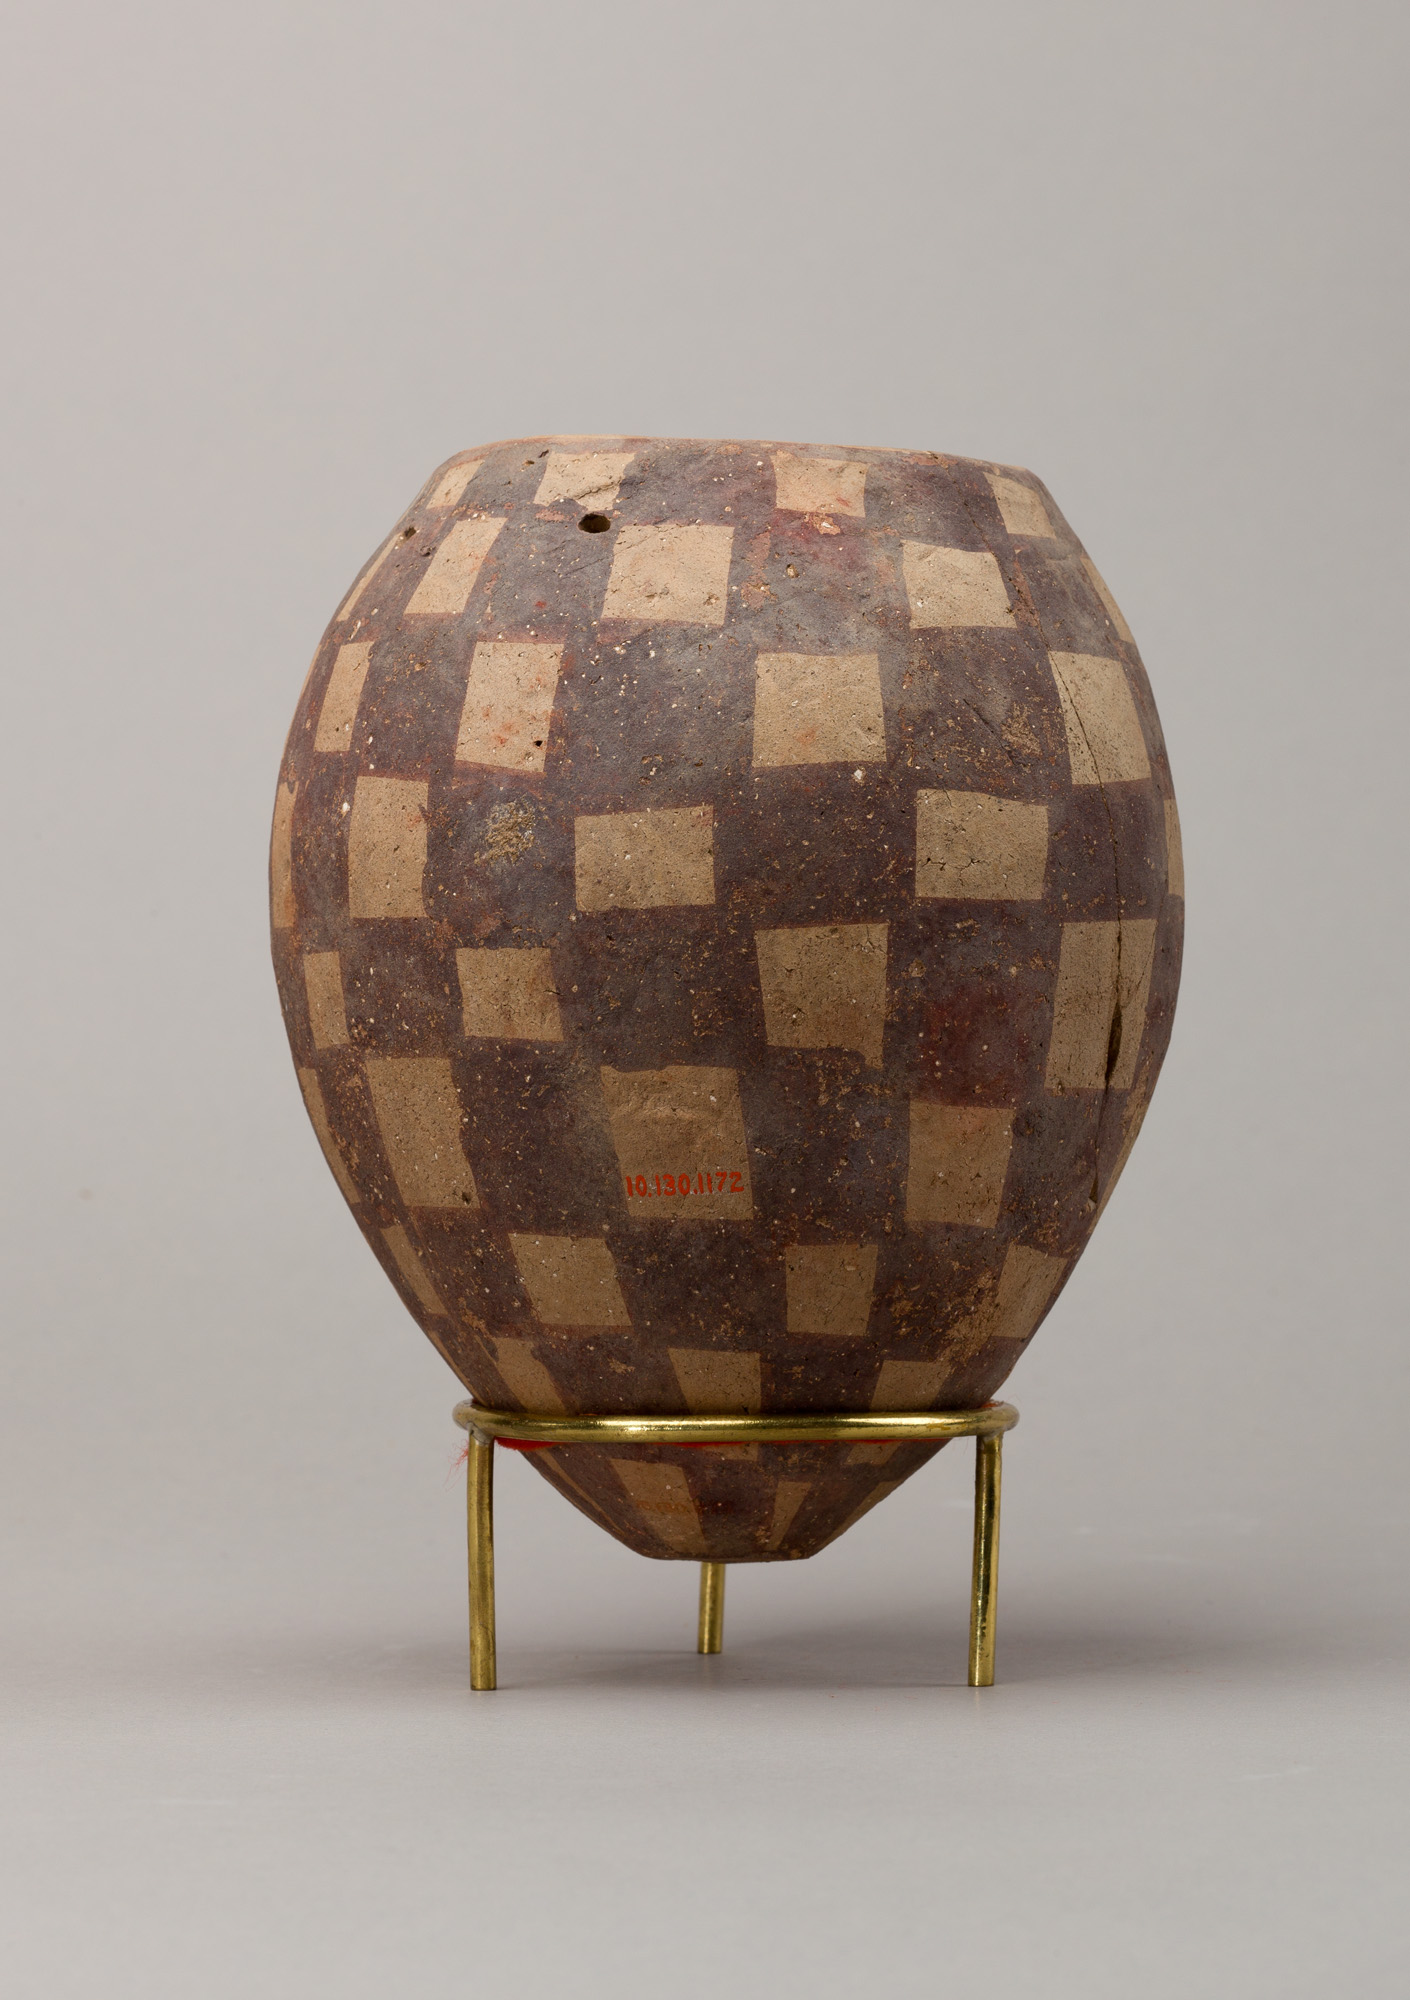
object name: jar, decorated ware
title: Jar decorated with checkerboard pattern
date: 3850-2960 BCE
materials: paint, pottery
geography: egypt